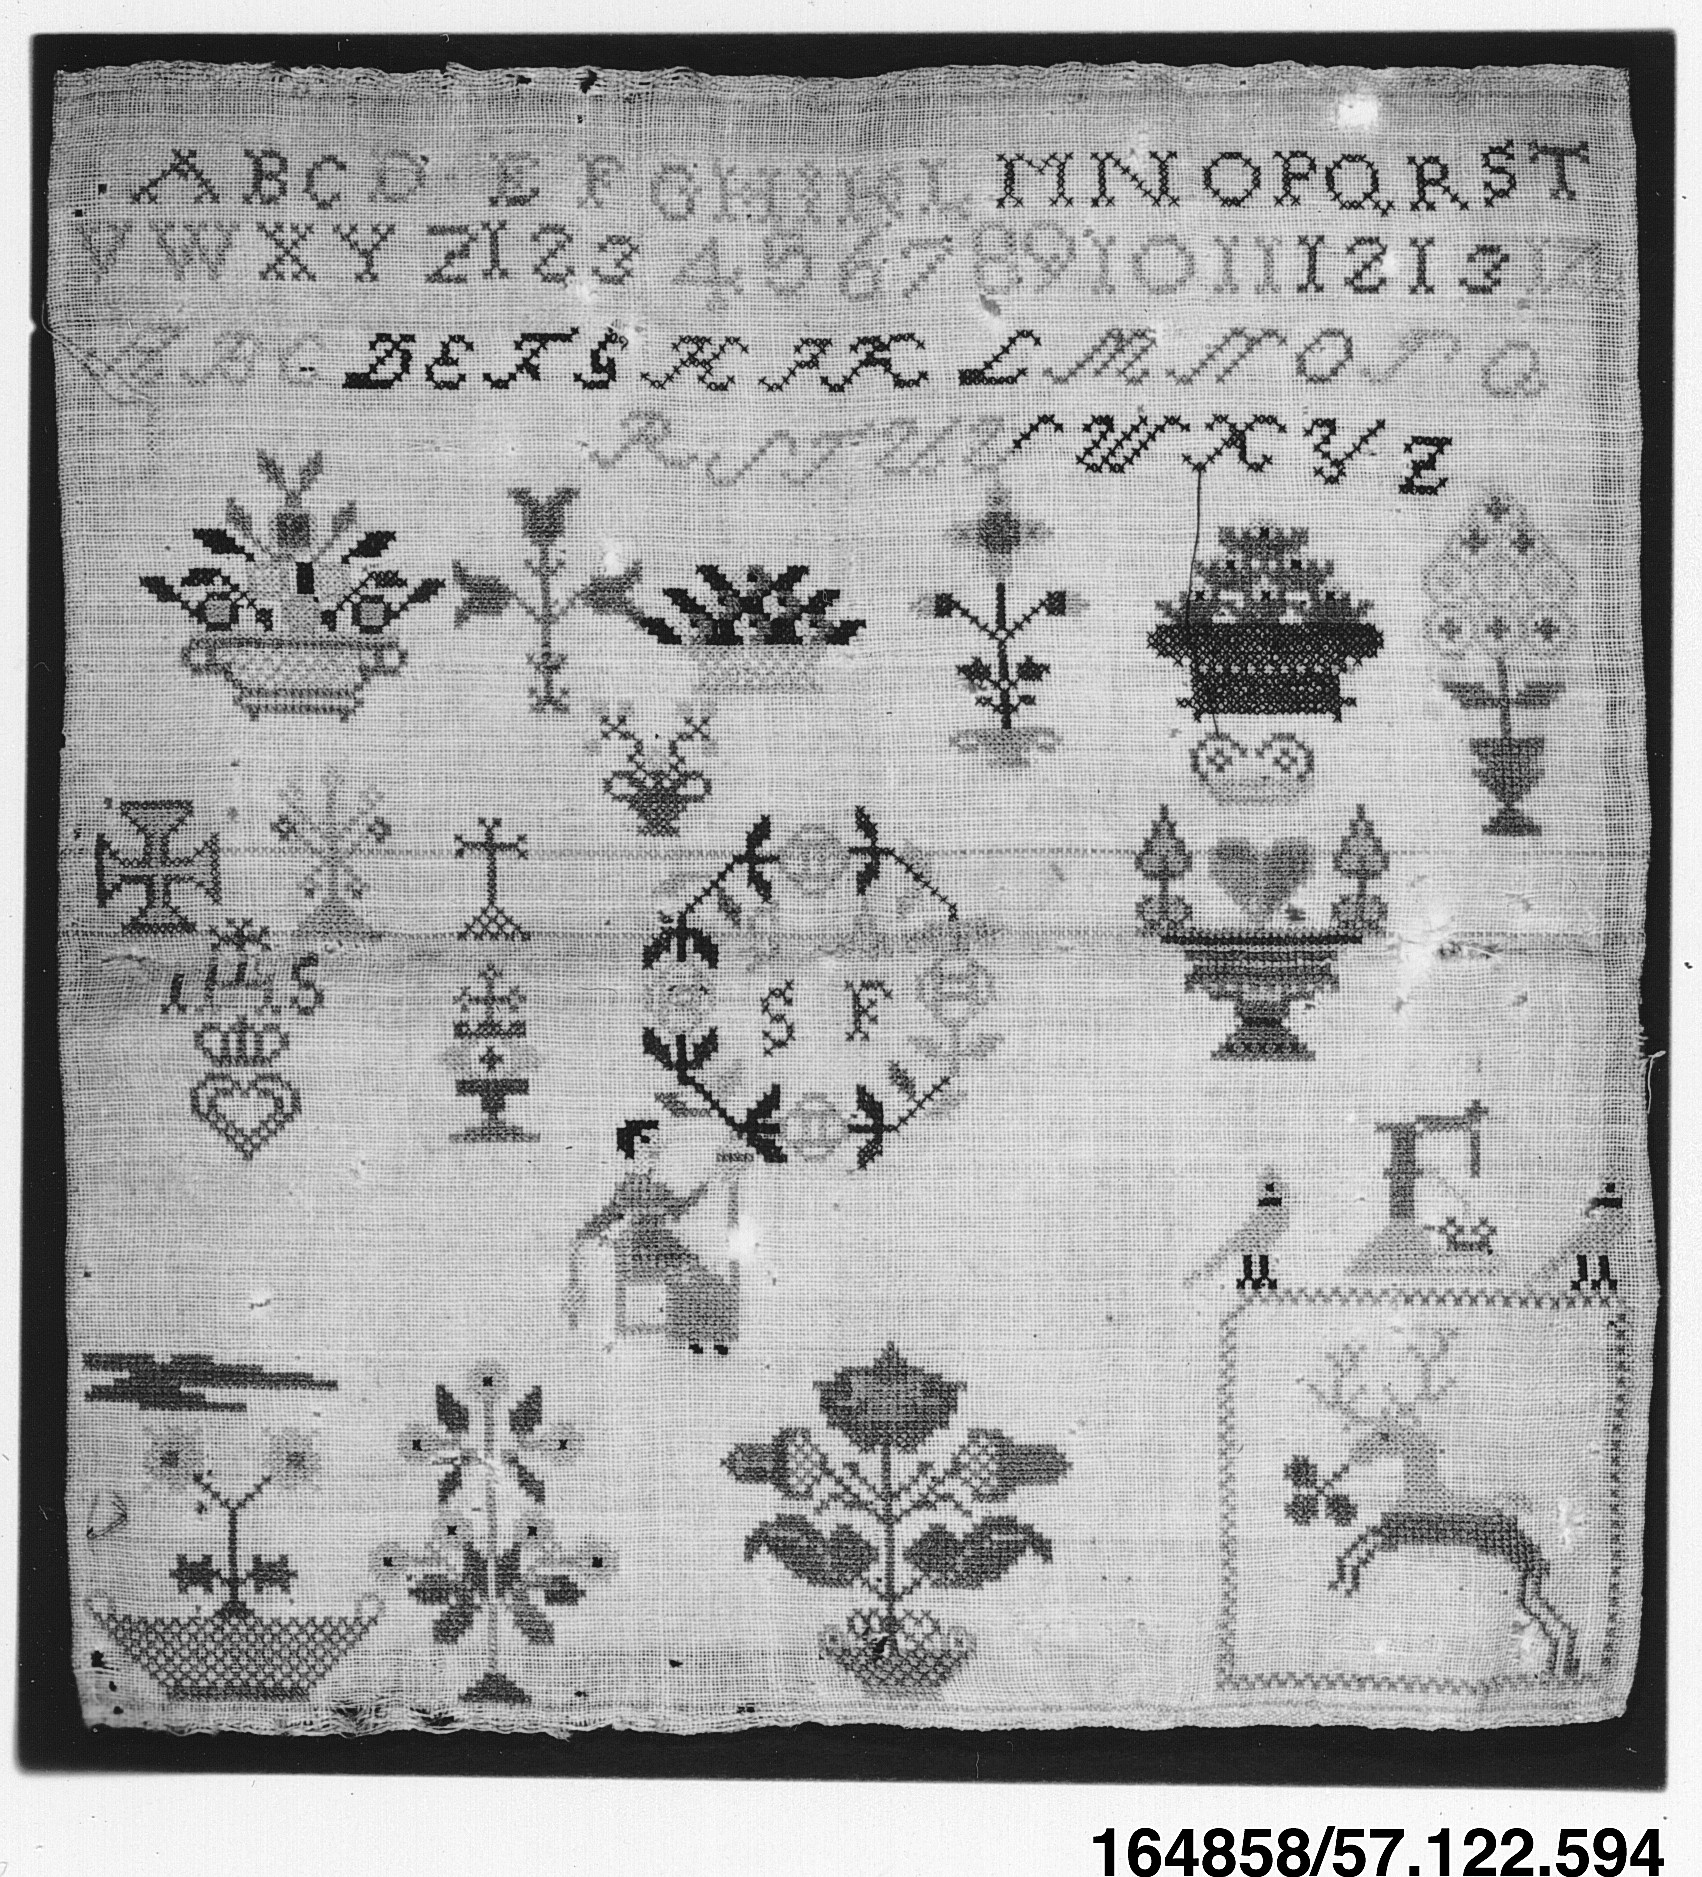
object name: sampler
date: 1801-1900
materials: canvas, silk, wool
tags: deer,flowers,insignia